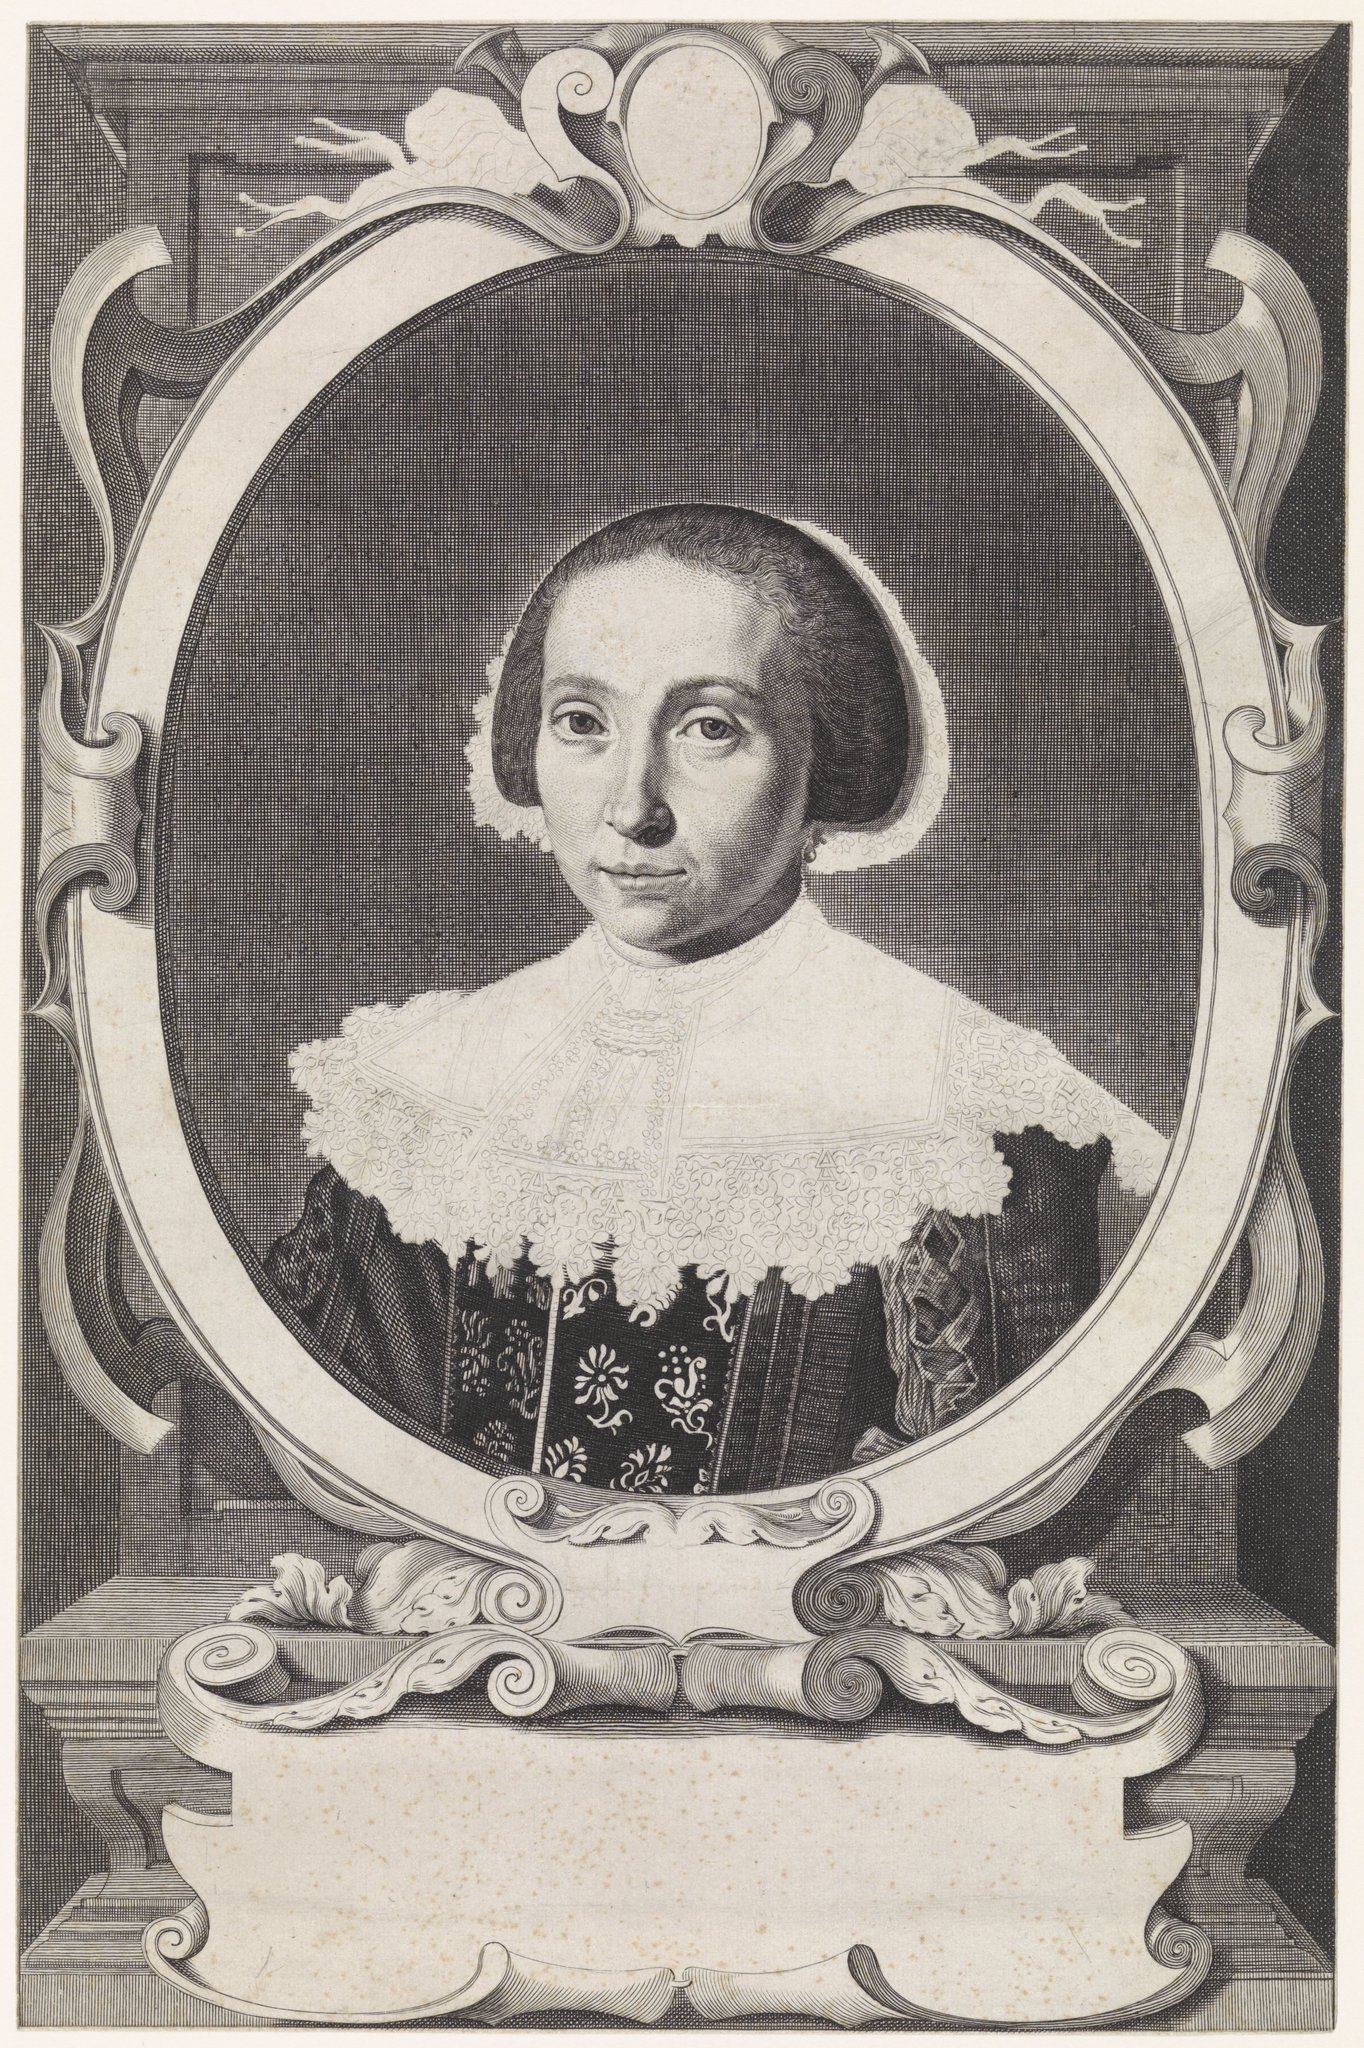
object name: print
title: Portret van Judith Cotermans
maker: theodor matham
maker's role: draughtsman, print maker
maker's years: 1605-1676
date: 1638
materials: paper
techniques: drypoint, engraving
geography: northern netherlands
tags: dordrecht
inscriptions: collector's mark: Lugt 2228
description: Portret van Judith Cotermans, vrouw van de Amsterdamse kalligraaf Henrik Meurs.